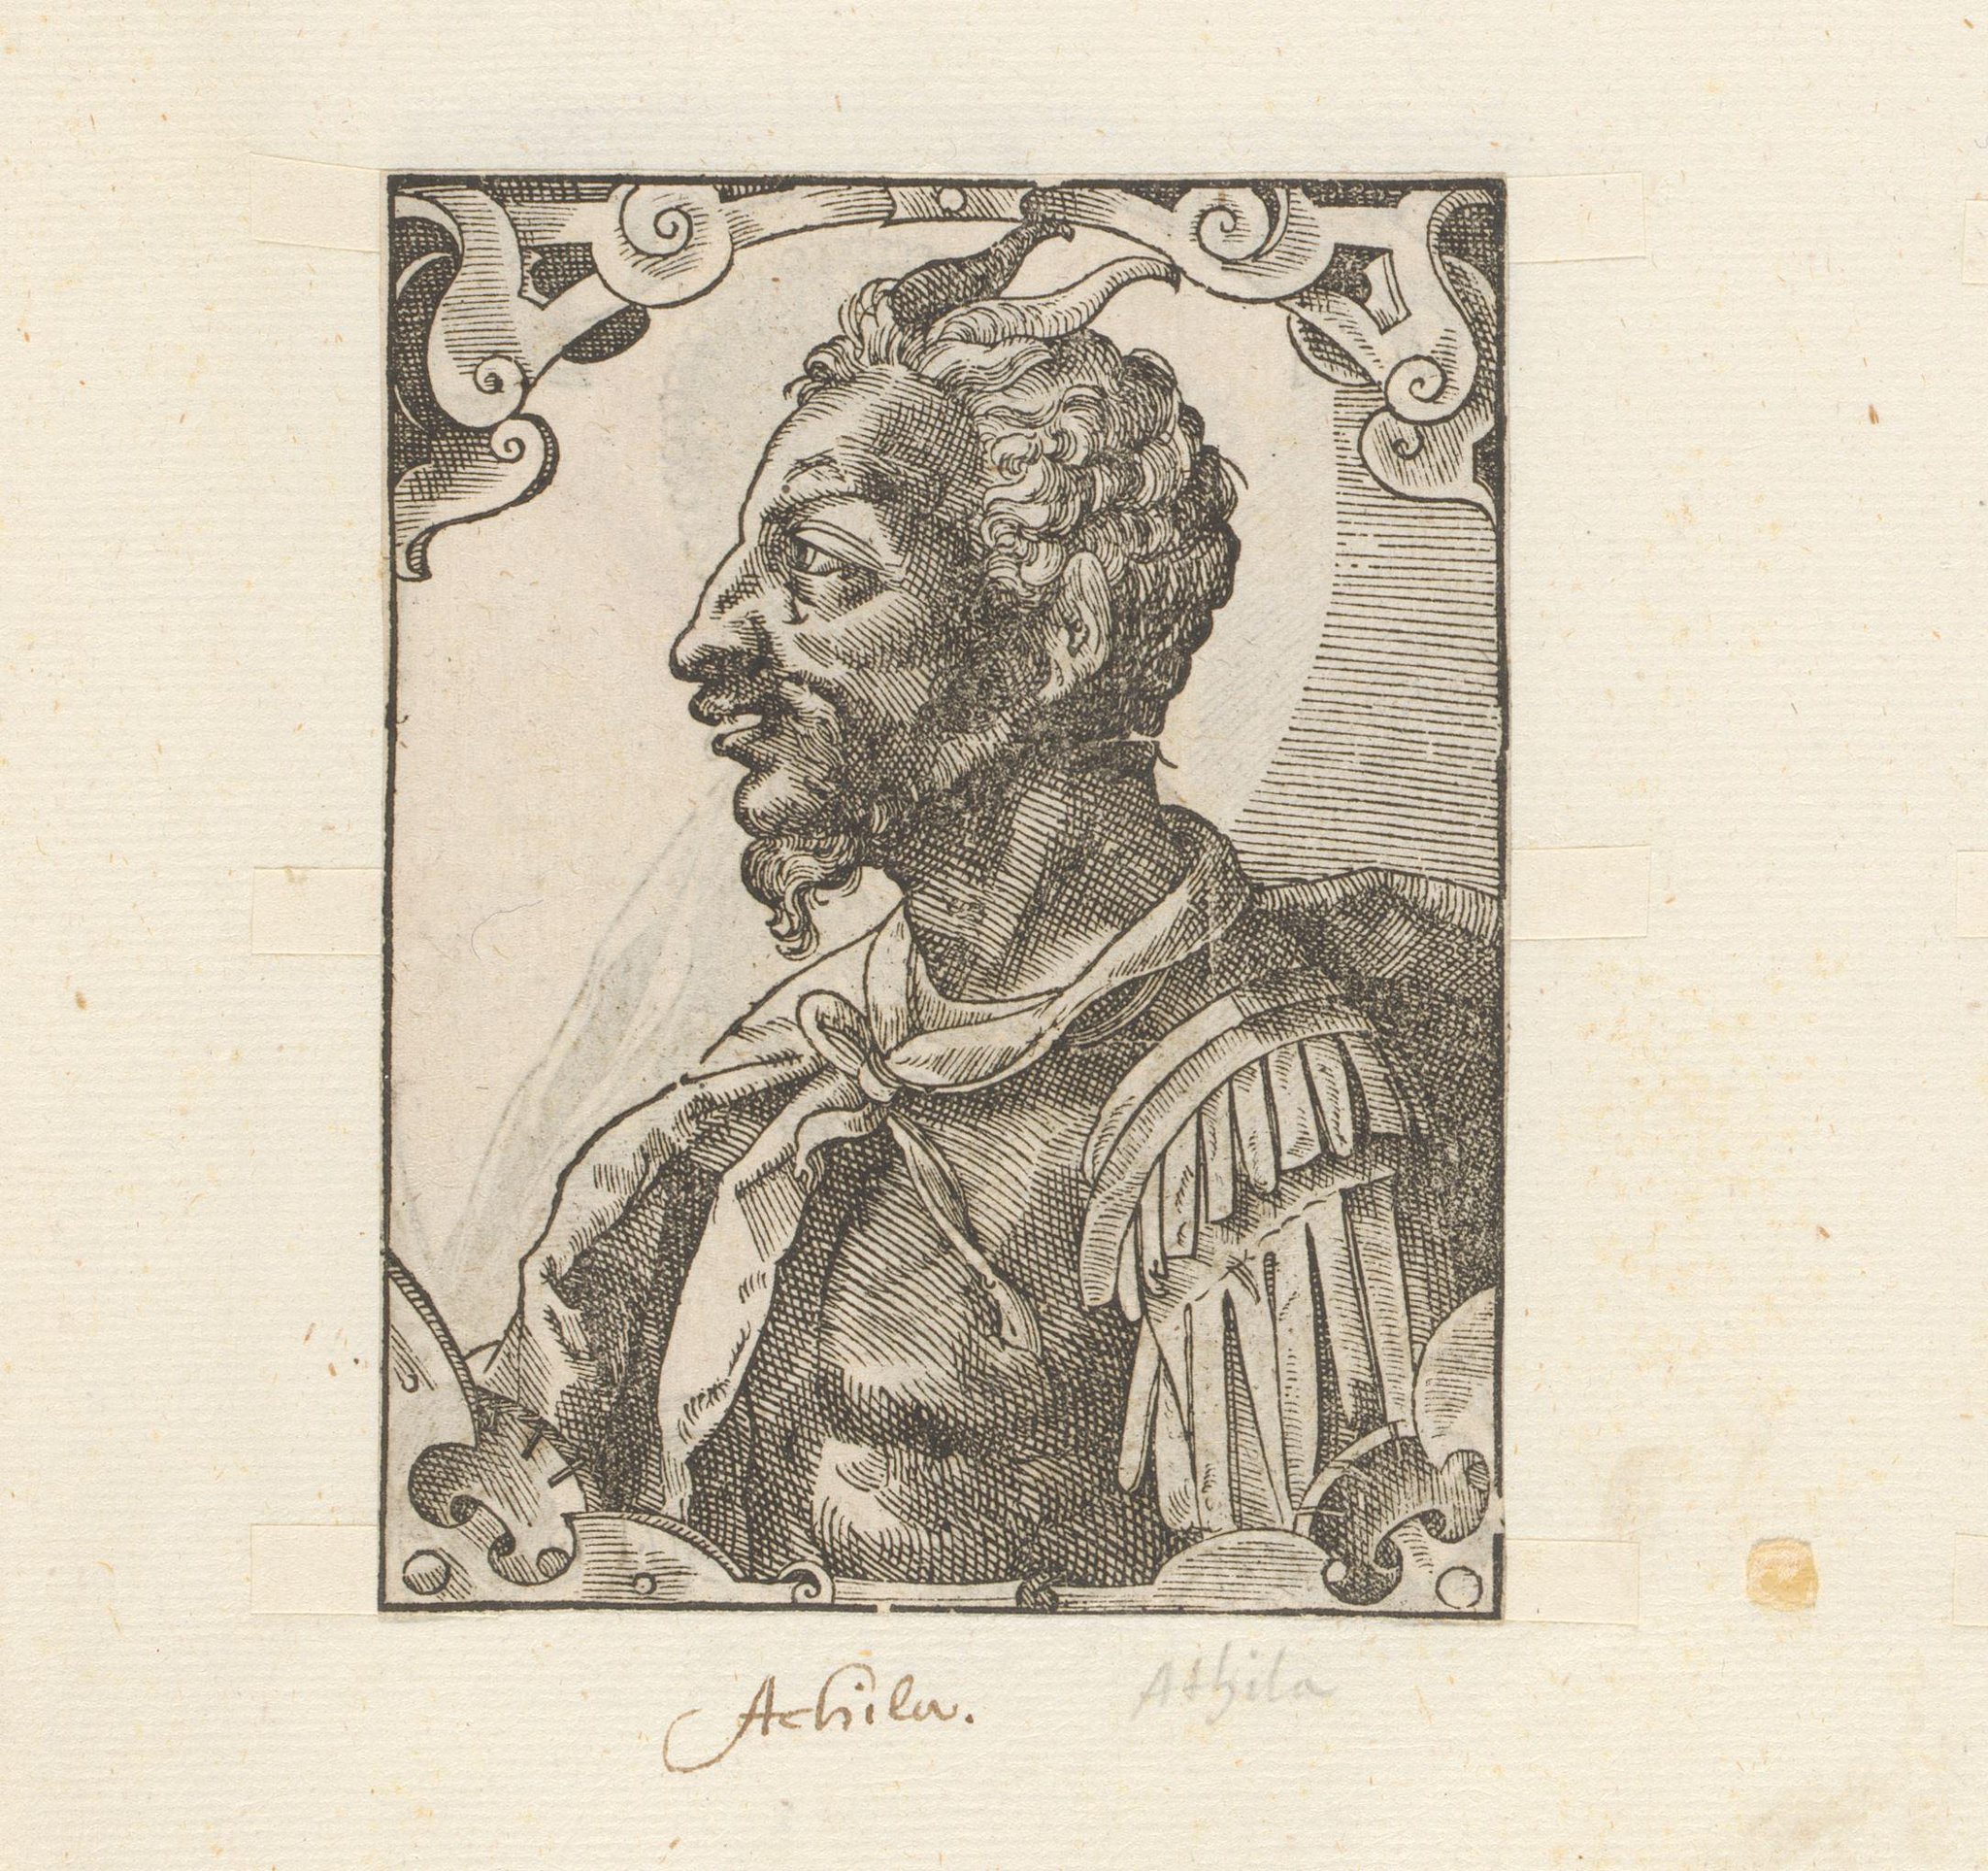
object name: print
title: Portret van Attila de Hun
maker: Anonymous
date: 1549-1575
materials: paper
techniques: woodcut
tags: historical persons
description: Prent gebruikt in: Giovio, Paolo. Elogia Virorum bellica virtute illustrium (...). Bazel: Peter Perna, 1575.